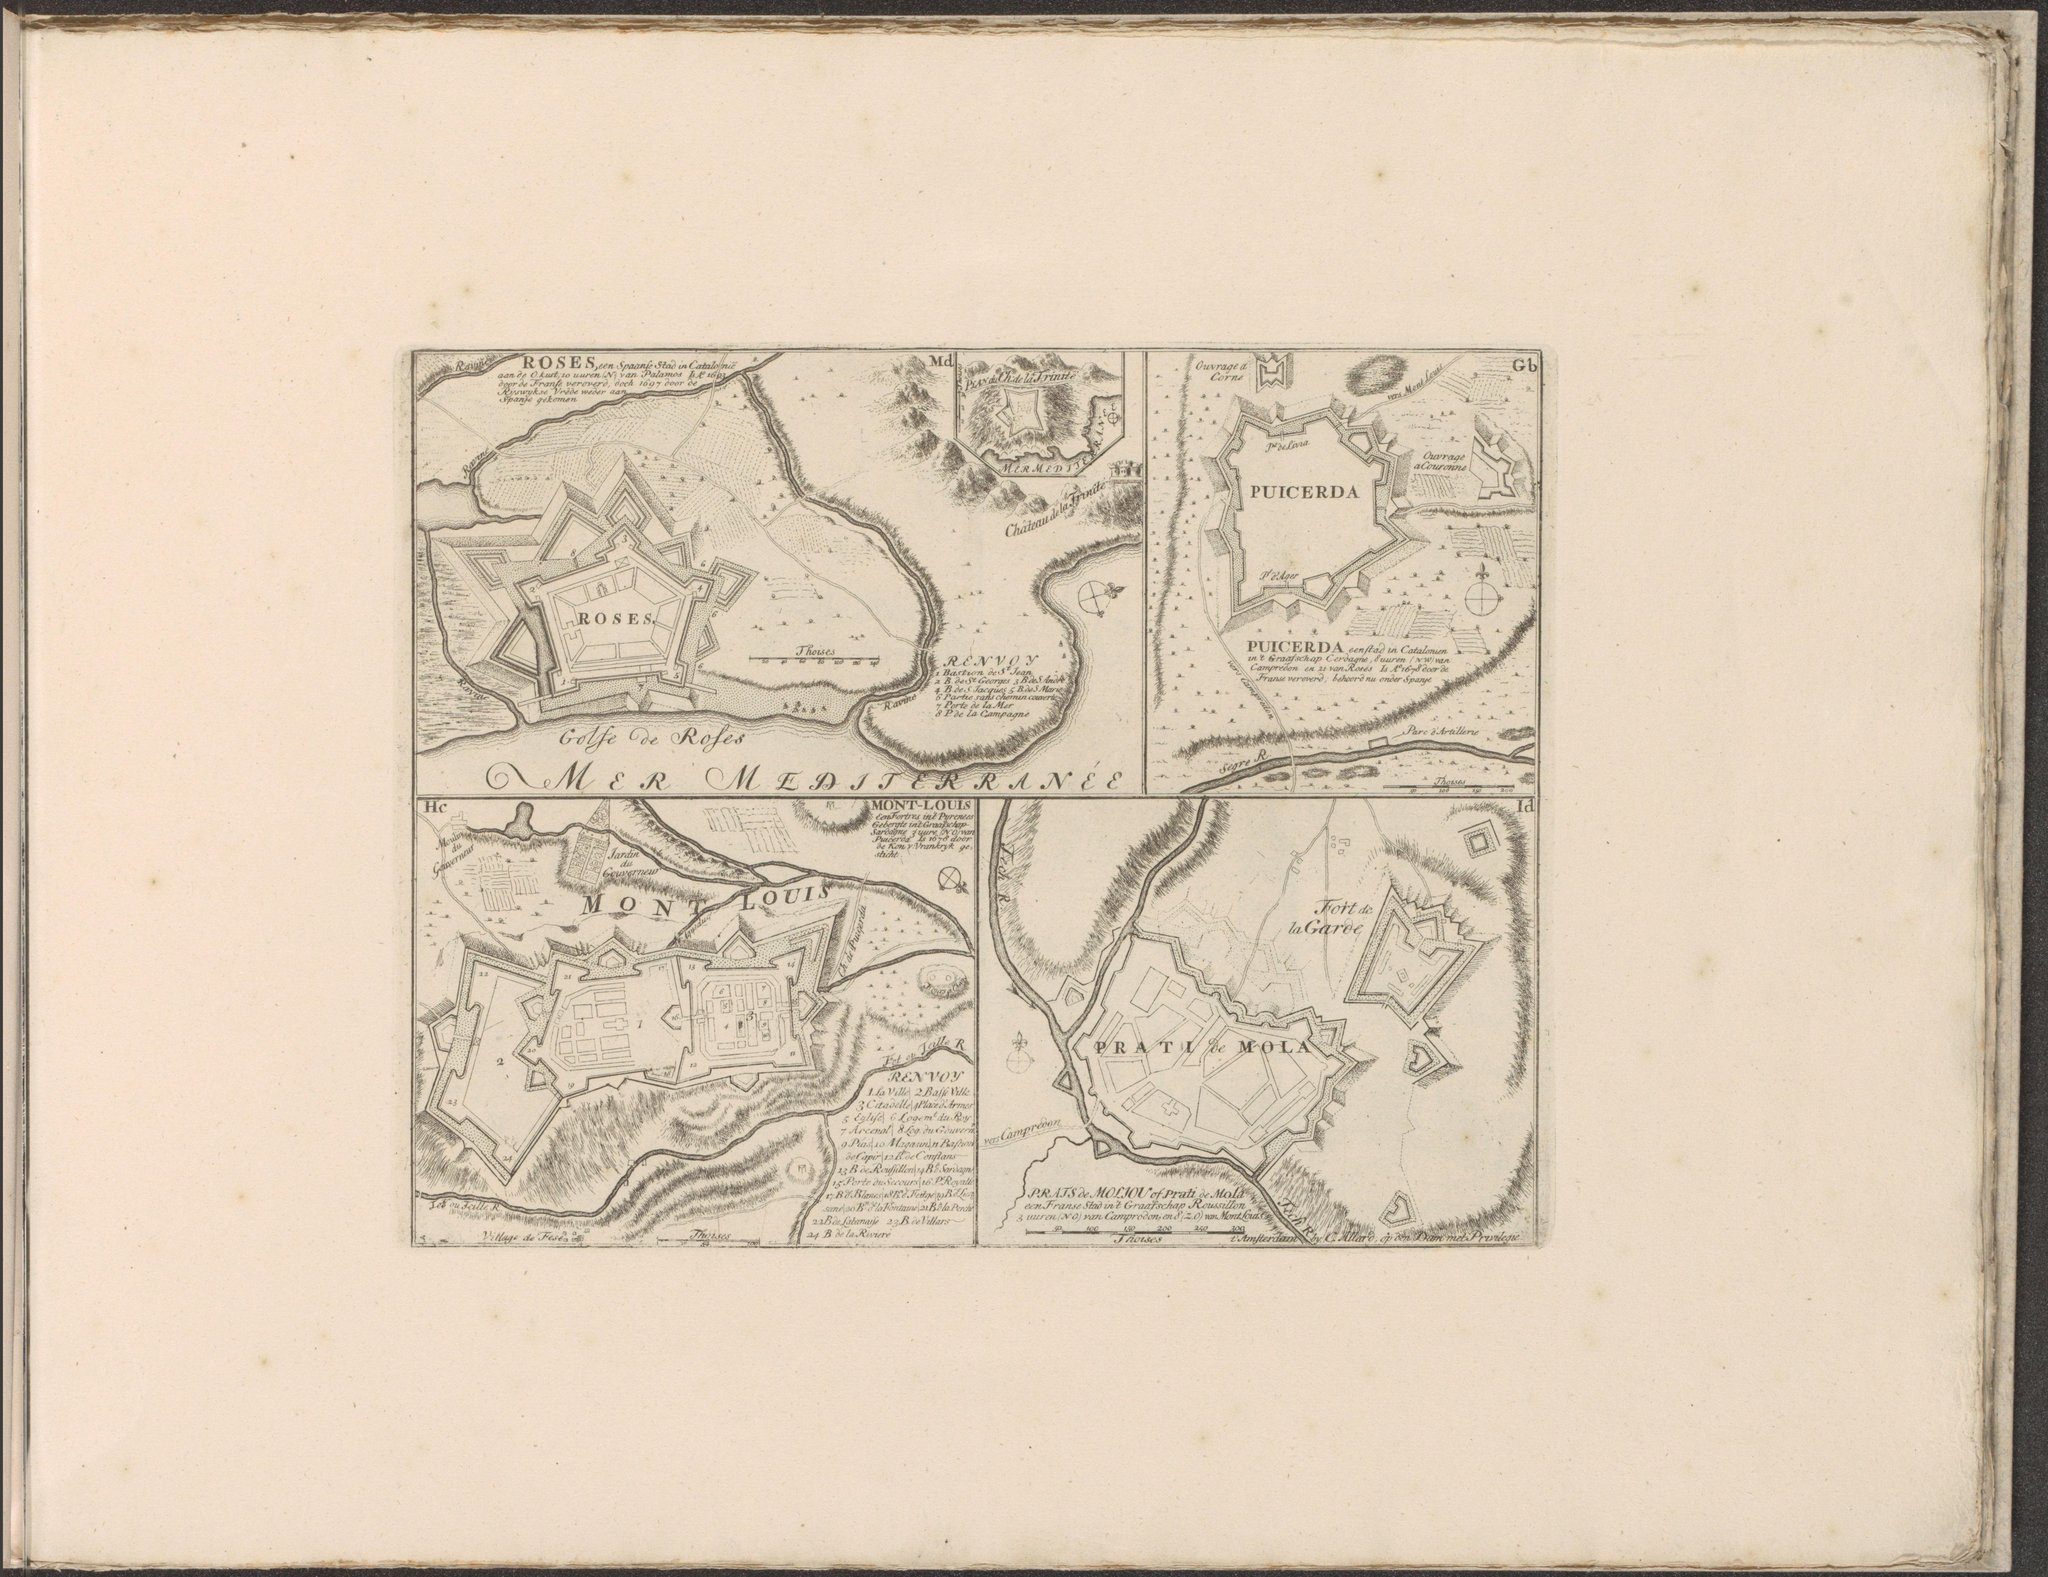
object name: album leaf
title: Les Principales Forteresses & Villes Fortes, d'Espagne, de France, d'Italie, de Savoië, d'Allemagne & des Païs-Bas (...) / Naaukeurige Afbeeldingen der Voornaamste Sterke Steden en Vestingen in Spanjen, Vrankryk, Italien, Savoyen, Duytsland en Nederlanden (...)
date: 1701-1733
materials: paper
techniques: etching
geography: amsterdam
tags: fortifications, military engineering, maps of cities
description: Voorstelling met vier kaarten van steden in Catalonië en Zuid-Frankrijk ten tijde of net voor de Spaanse Successieoorlog. Met teksten in het Nederlands en Frans. De prent maakt deel uit van een album.